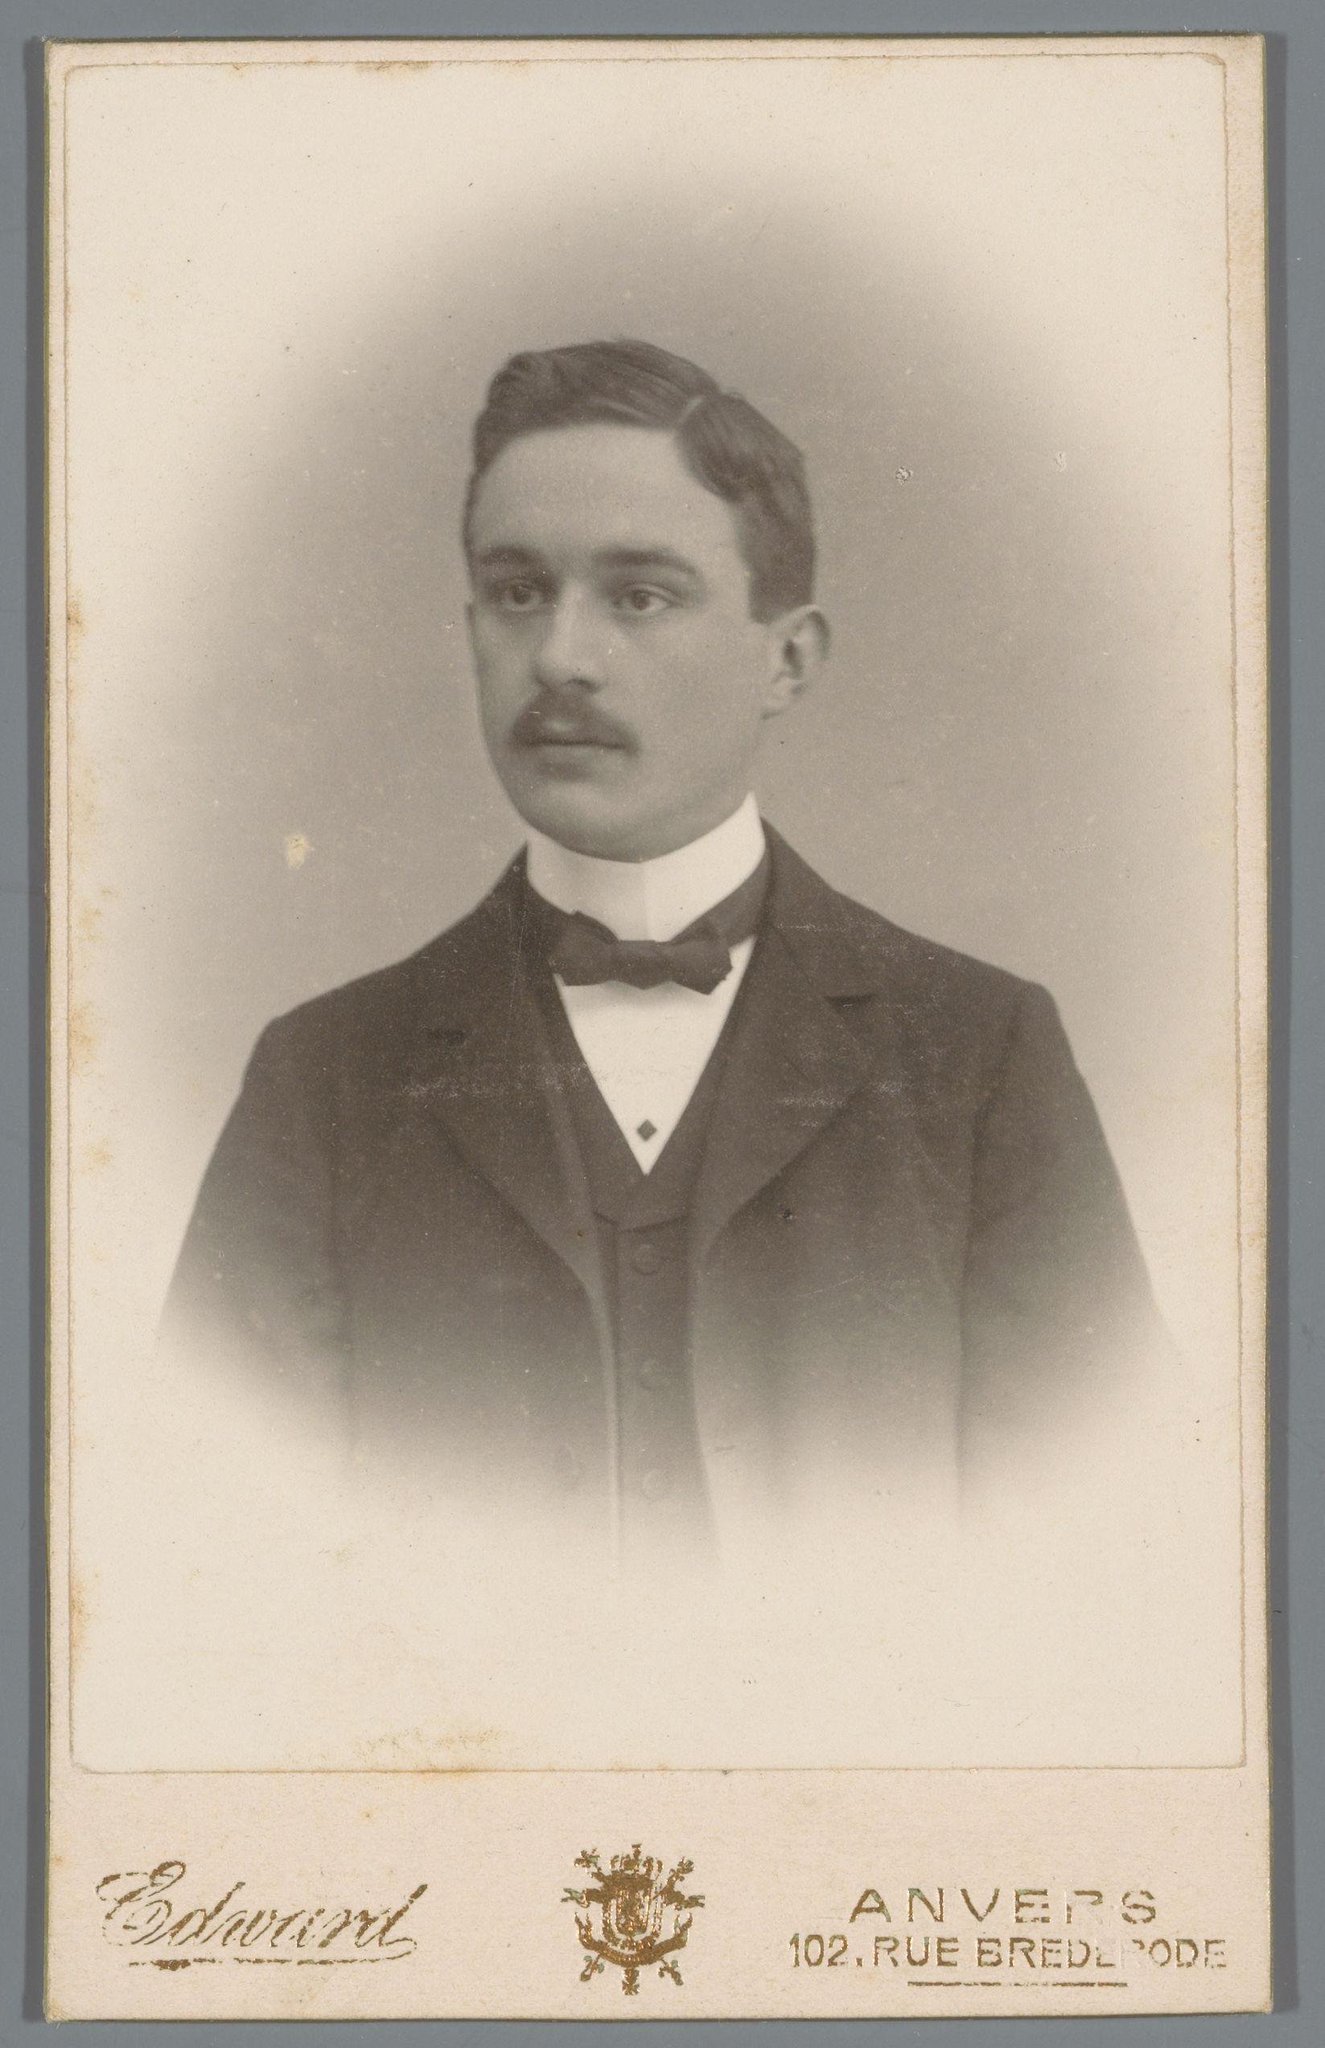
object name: carte de visite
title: Portret van een onbekende man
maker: edward van boghout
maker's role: fotograaf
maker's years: 1855-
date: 1901-1908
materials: paper, cardboard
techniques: gelatin silver print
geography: antwerp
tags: adult man, anonymous historical person portrayed, antwerp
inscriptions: inscription: ‘Photographie/ Edward/ Anvers/ 102, Rue Brederode 102/ Atelier de pose au jardin/ Les clichés sont conservés’, inscription: ‘Edward/ Anvers/ 102, Rue Brederode’